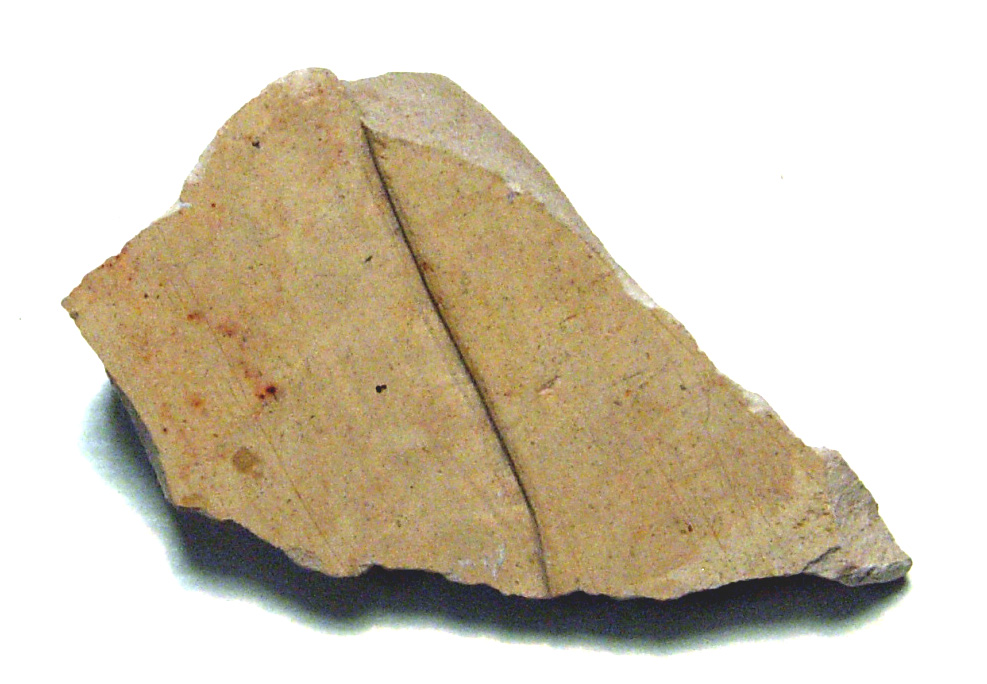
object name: relief, tomb of nespekashuty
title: Raised relief fragment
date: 664-610 BCE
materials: limestone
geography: egypt